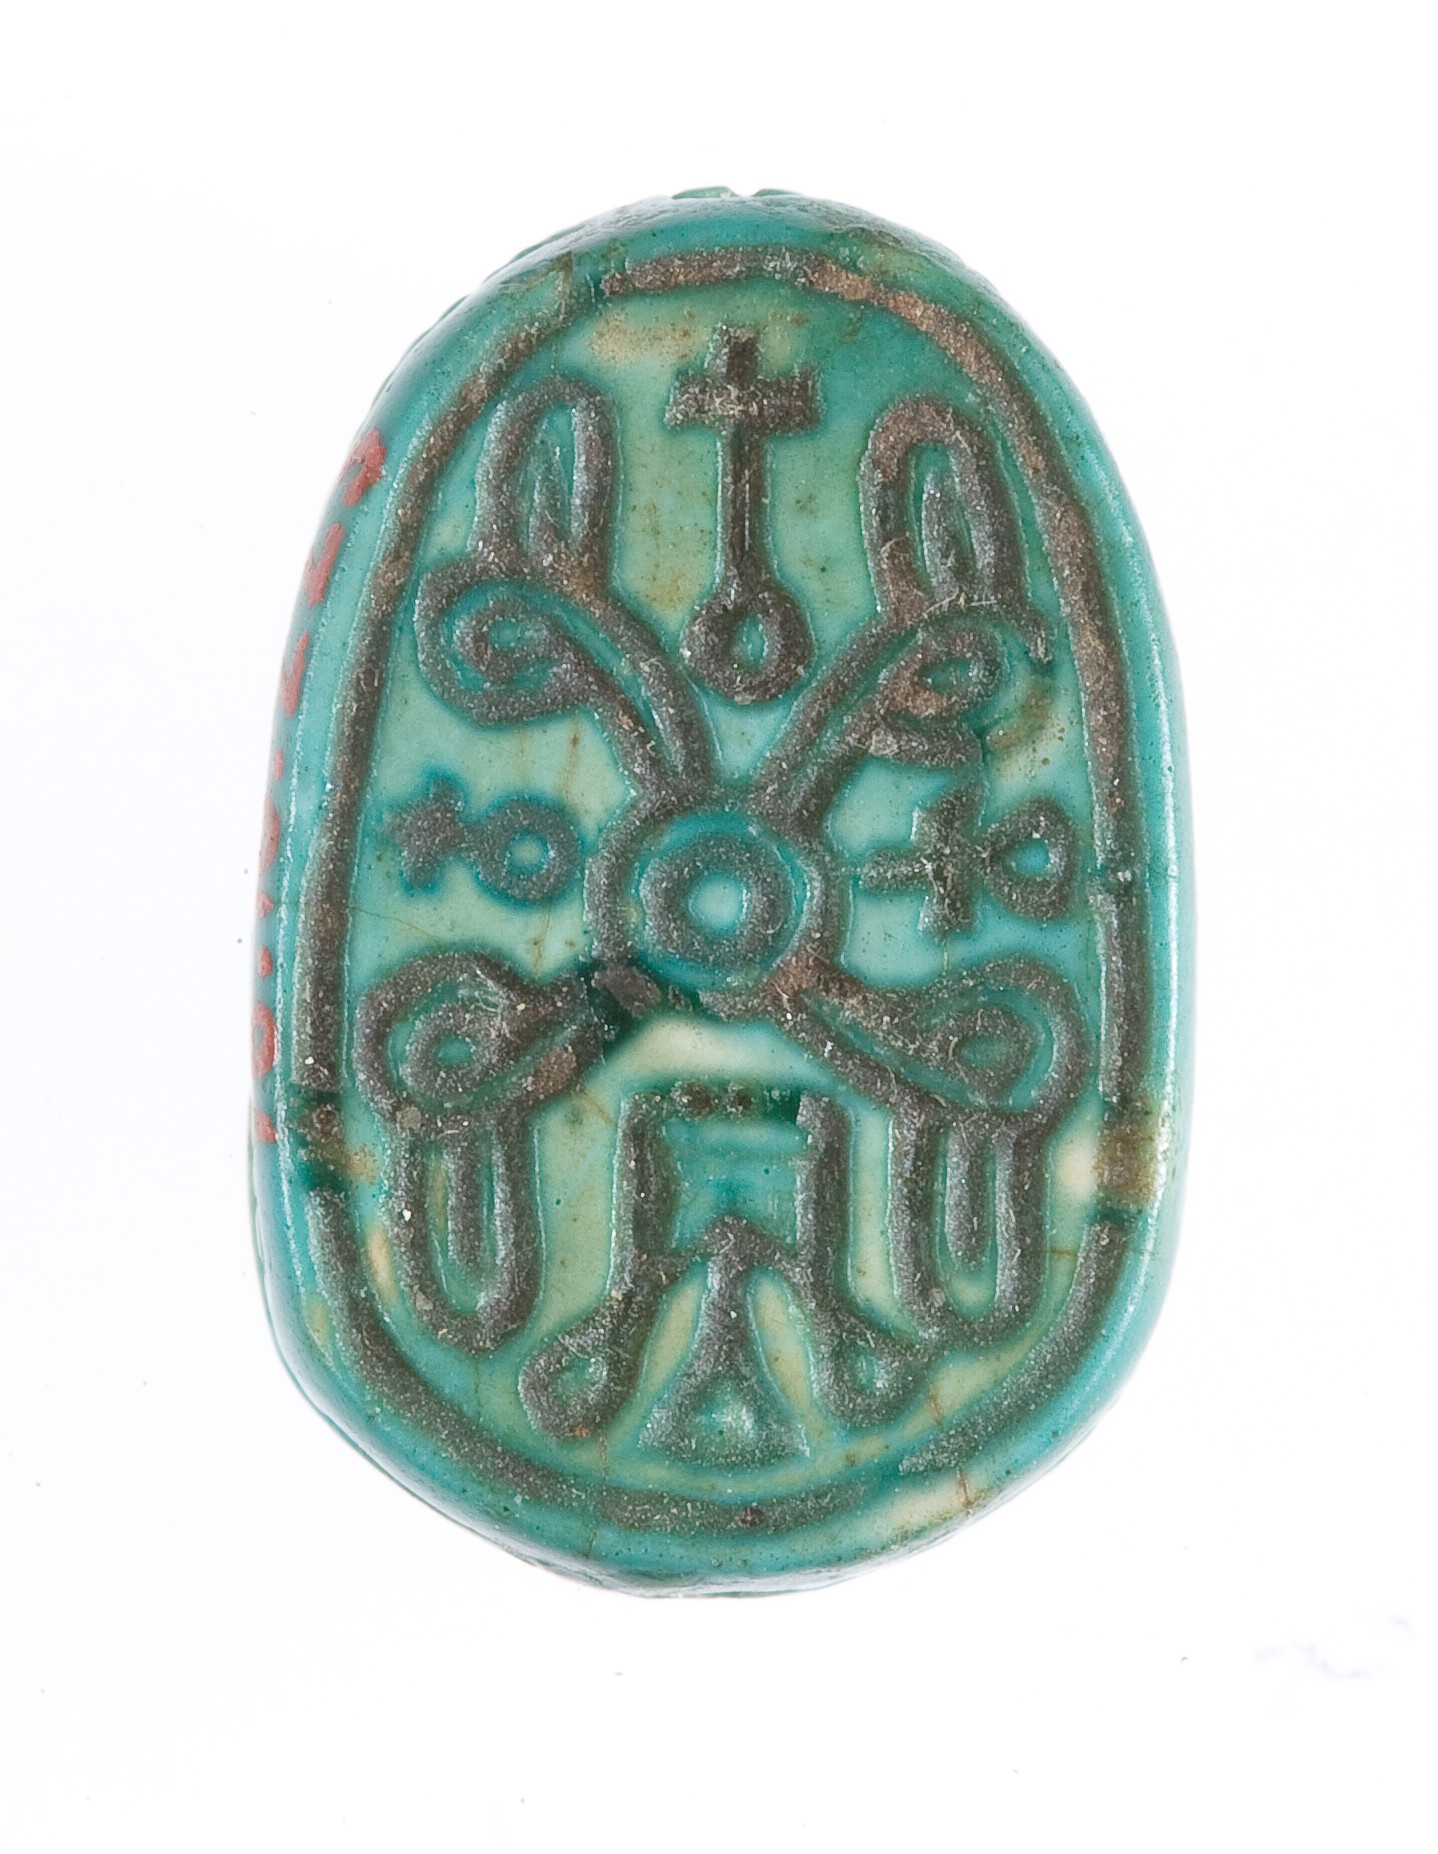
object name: scarab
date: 1635-1458 BCE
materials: stone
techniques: glazing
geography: egypt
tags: scarabs